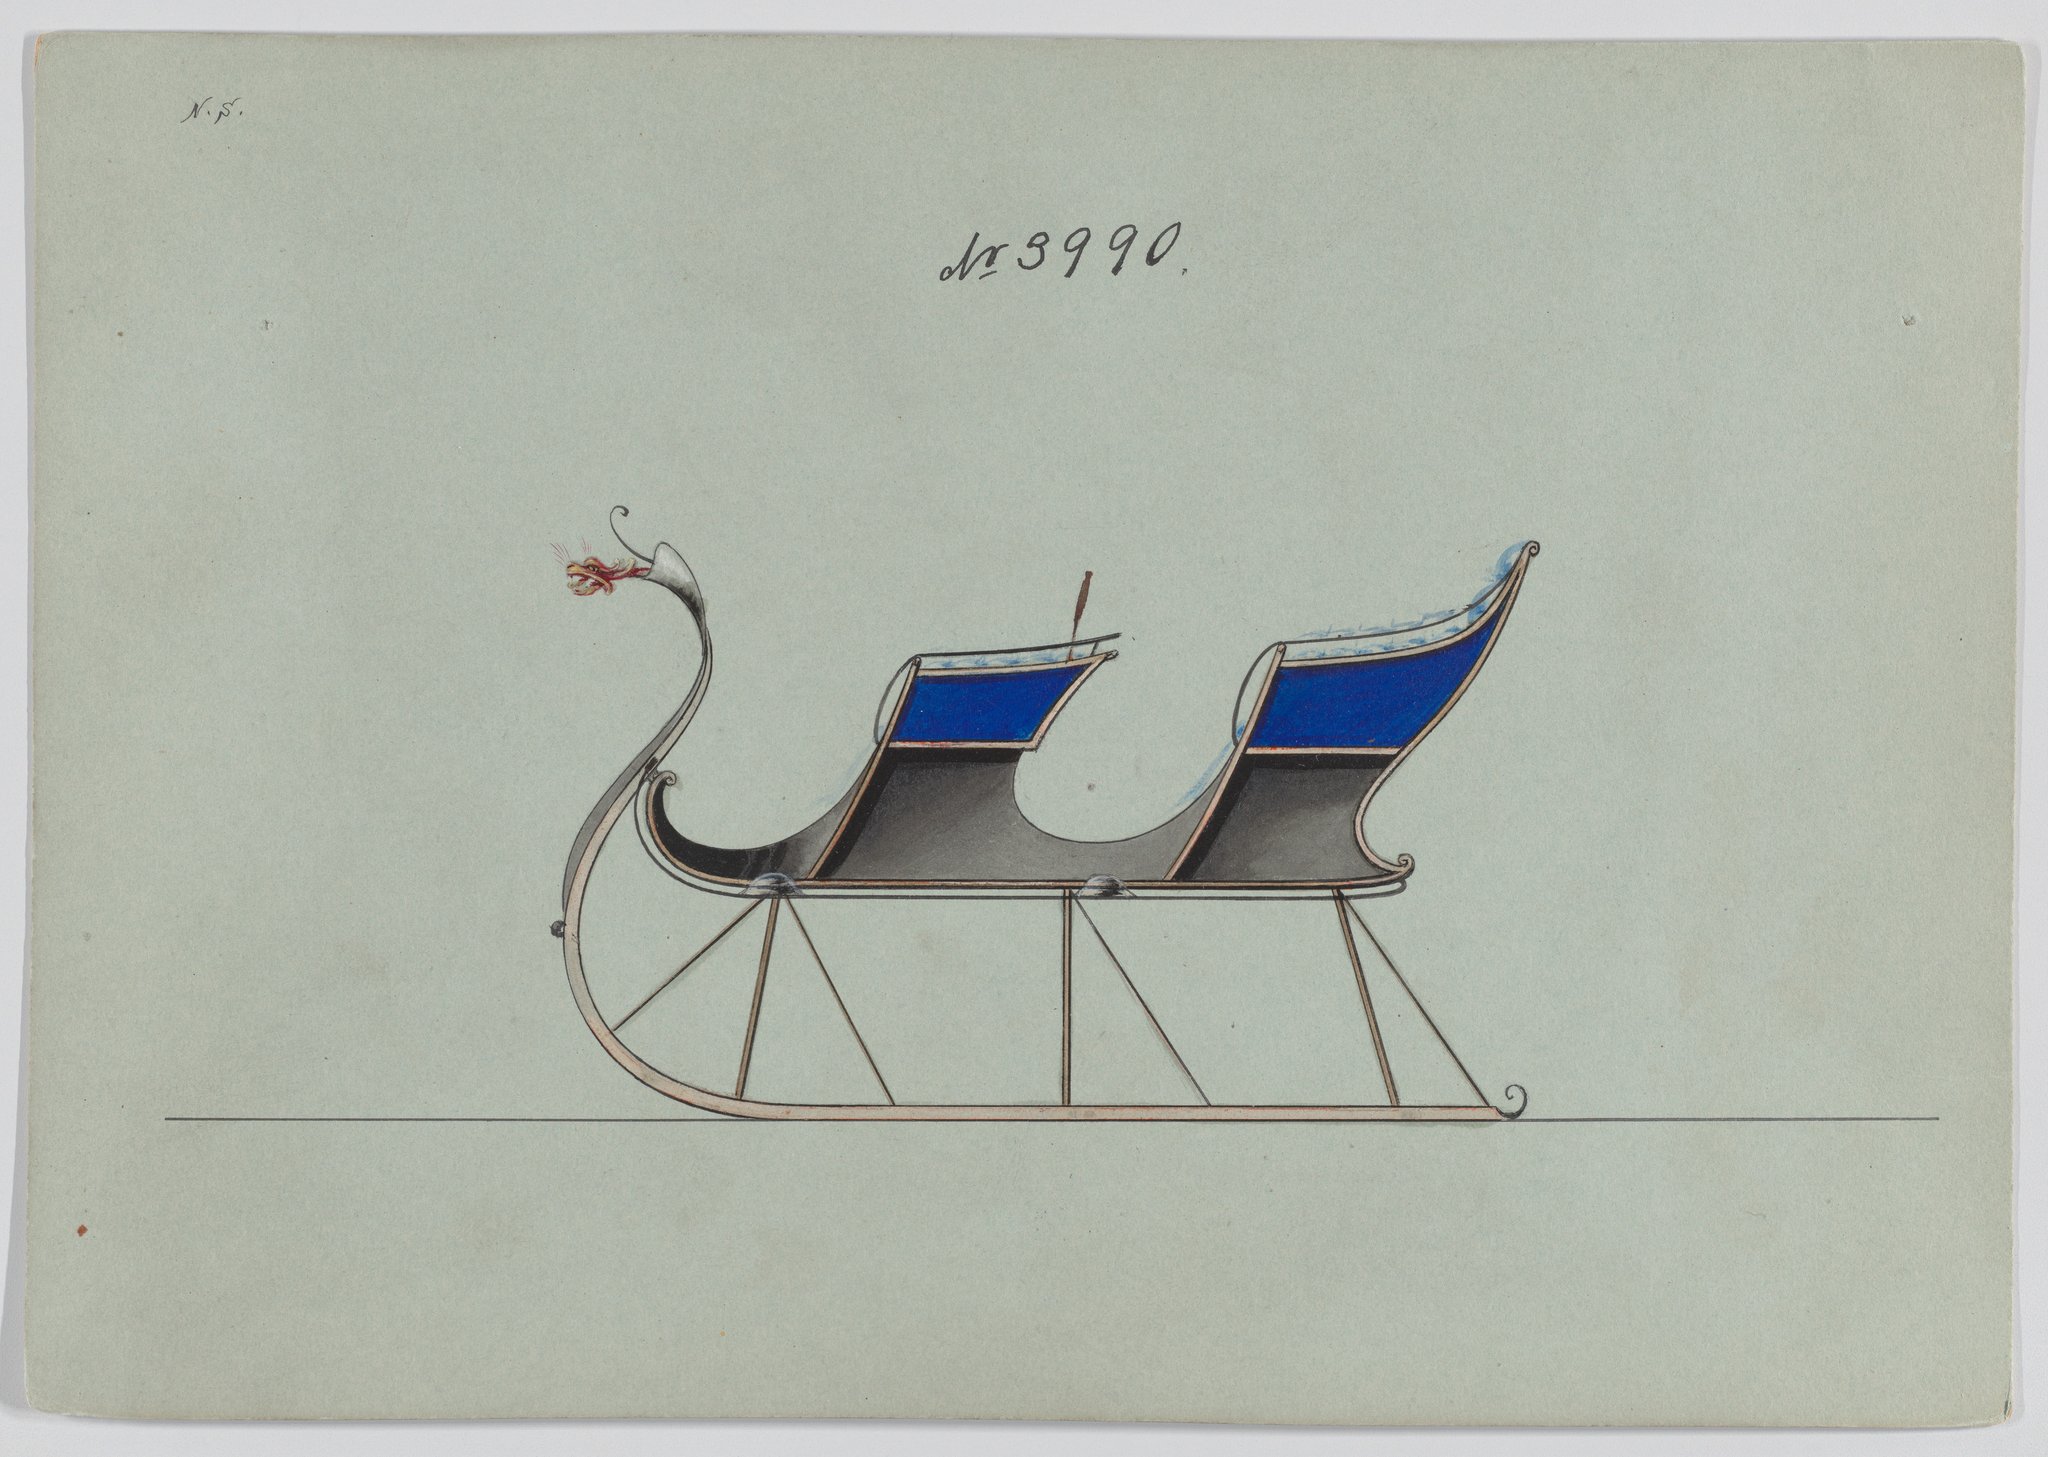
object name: drawing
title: Design for 2 Seat Sleigh, no. 3990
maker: brewster & co.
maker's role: manufacturer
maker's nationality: american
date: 1887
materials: gouache, gum arabic, ink, watercolor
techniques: pen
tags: sleighs